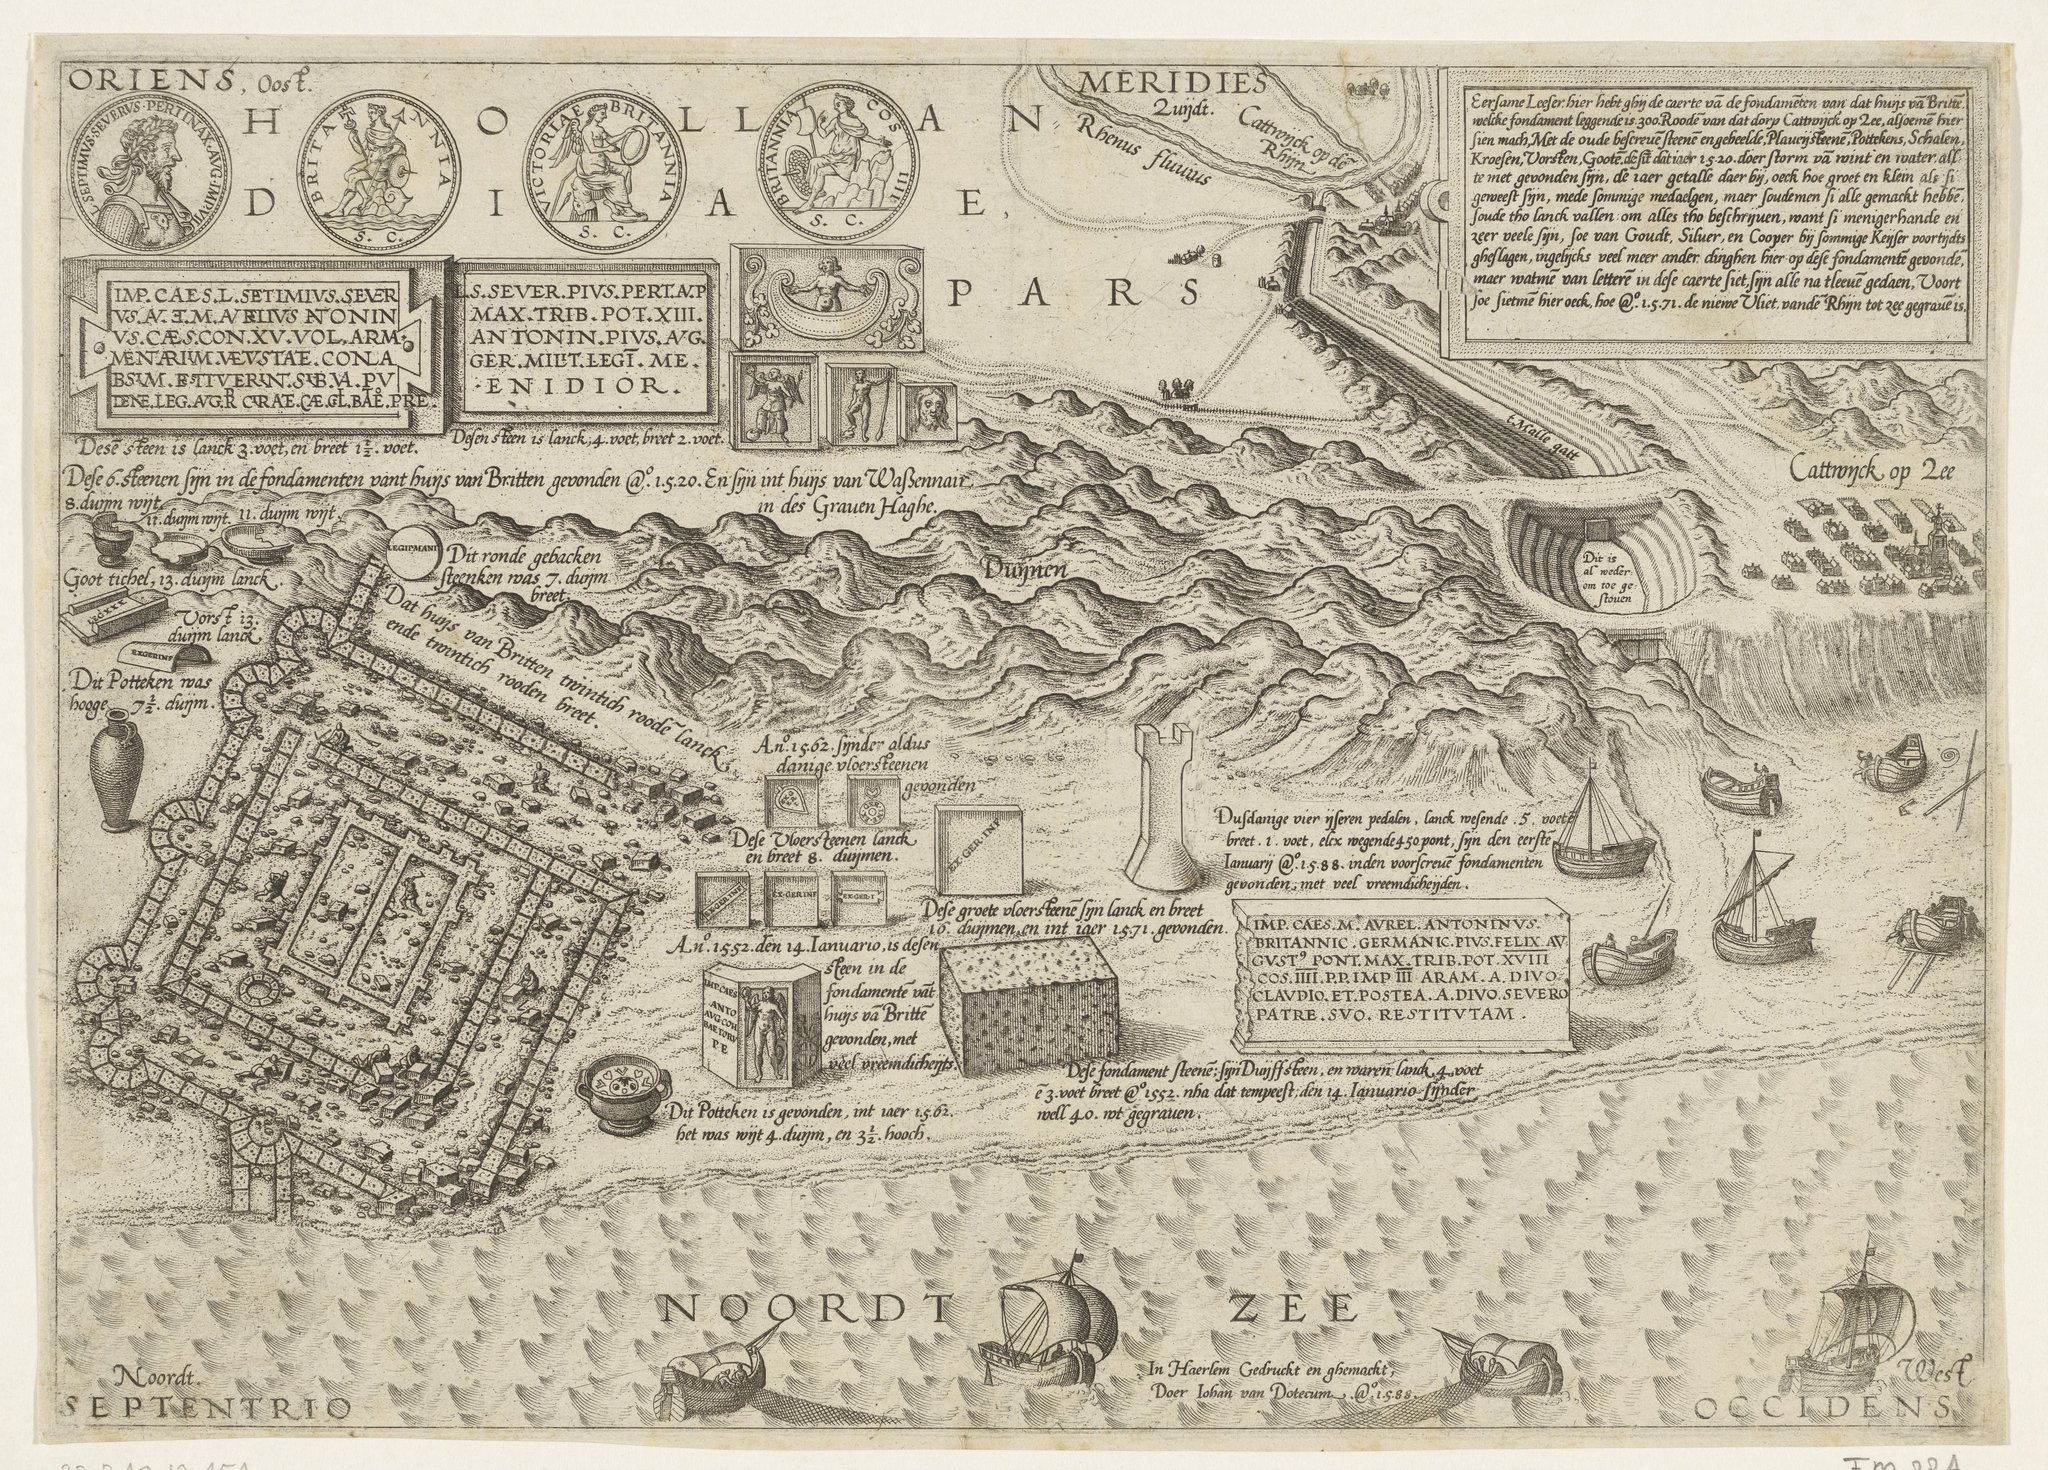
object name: historical object representation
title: Kustlandschap met de fundamenten van het Huis te Britten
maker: joannes van doetechum (i)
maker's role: print maker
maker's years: 1528-1605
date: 1588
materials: paper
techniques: engraving, etching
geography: haarlem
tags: landscape with ruins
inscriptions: collector's mark: Lugt 2228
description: Kustlandschap met plattegrond van de fundamenten van het Huis te Britten. Rechts bovenaan een cartouche met tekst in het Nederlands, verder enkele stenen en opschriften in het Latijn, enkele munten en andere vondsten. In het water en op het strand verschillende vissersbootjes.